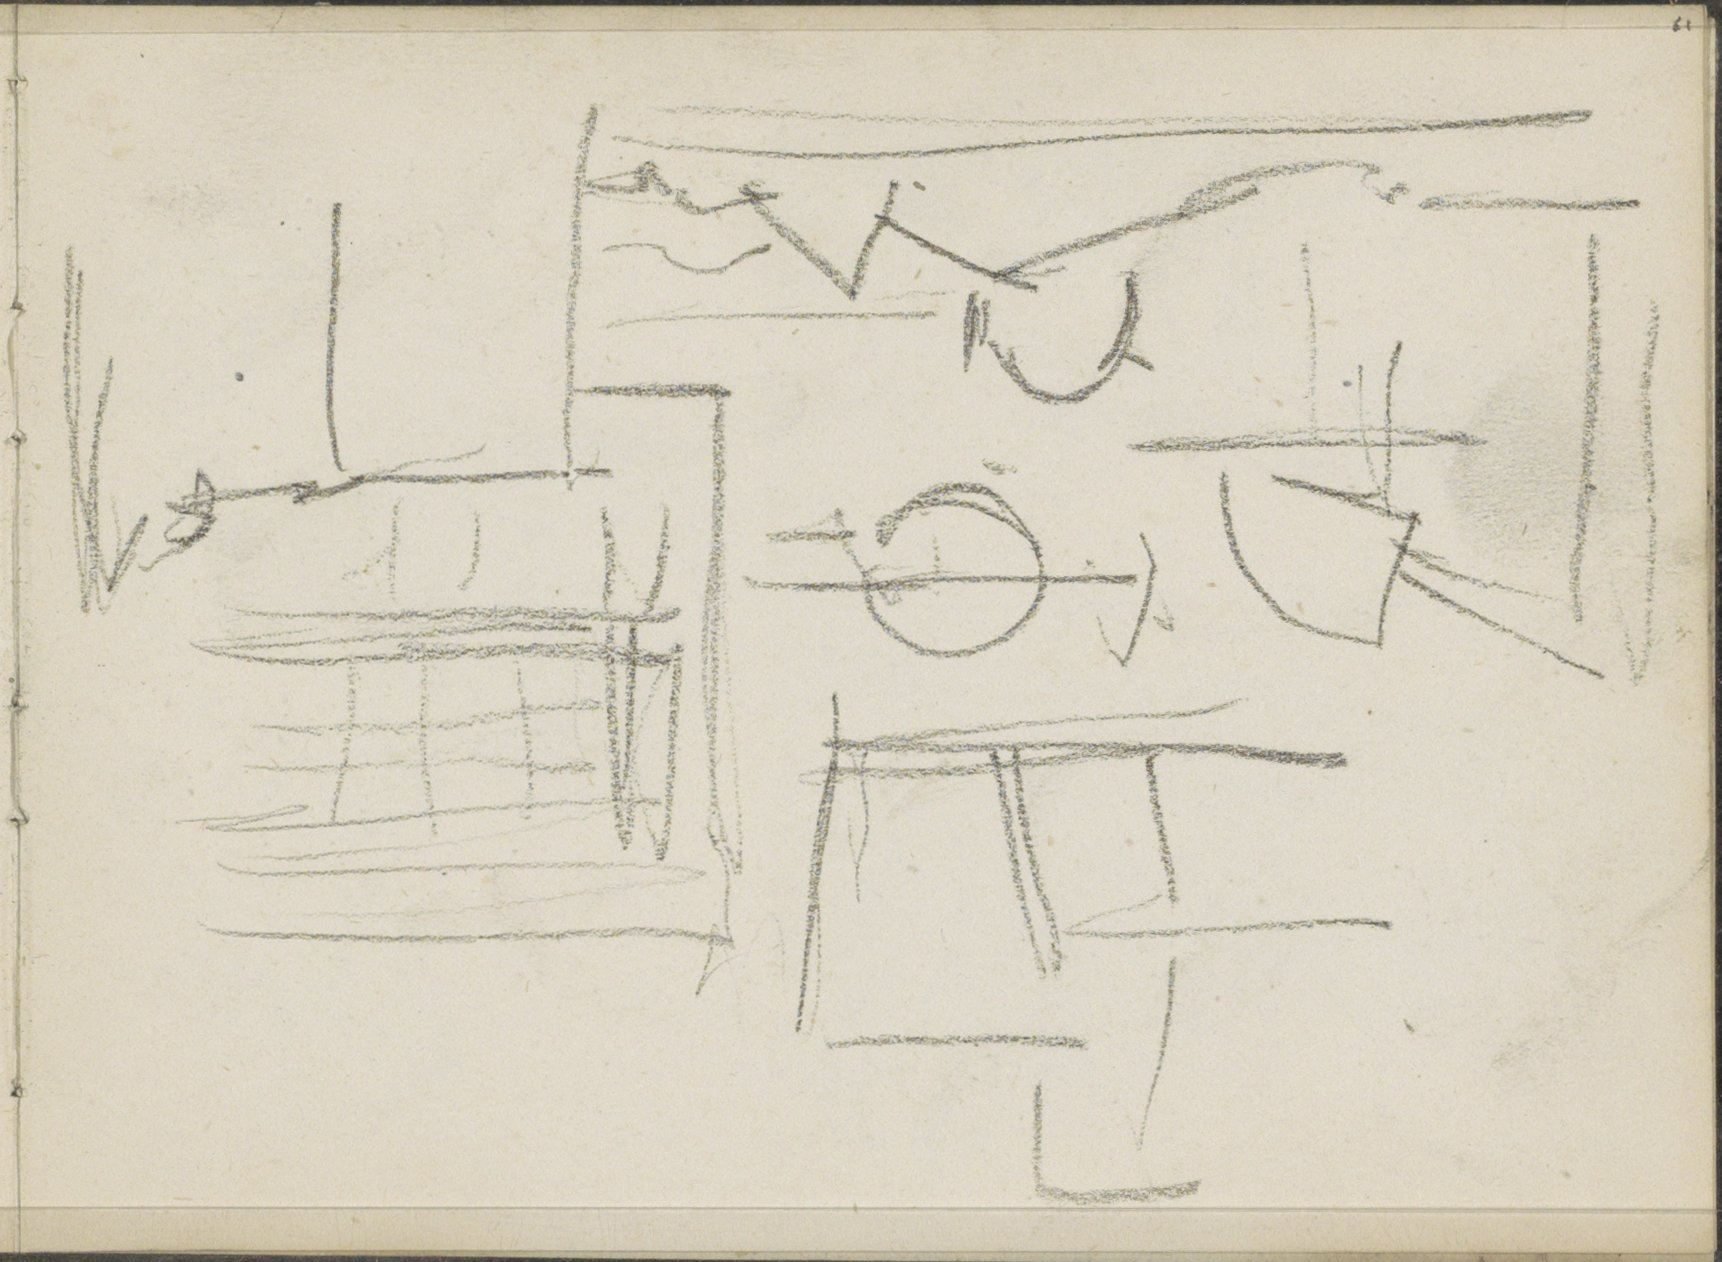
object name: sketchbook leaf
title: Studieblad, onder andere met een stoel en raam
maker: marius bauer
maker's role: draughtsman, print maker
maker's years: 1867-1932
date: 1877-1932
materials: chalk, paper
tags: interior of the house, chair, closed window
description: Mogelijk een studie van een interieur. Pagina 61 uit een schetsboek met 32 bladen.